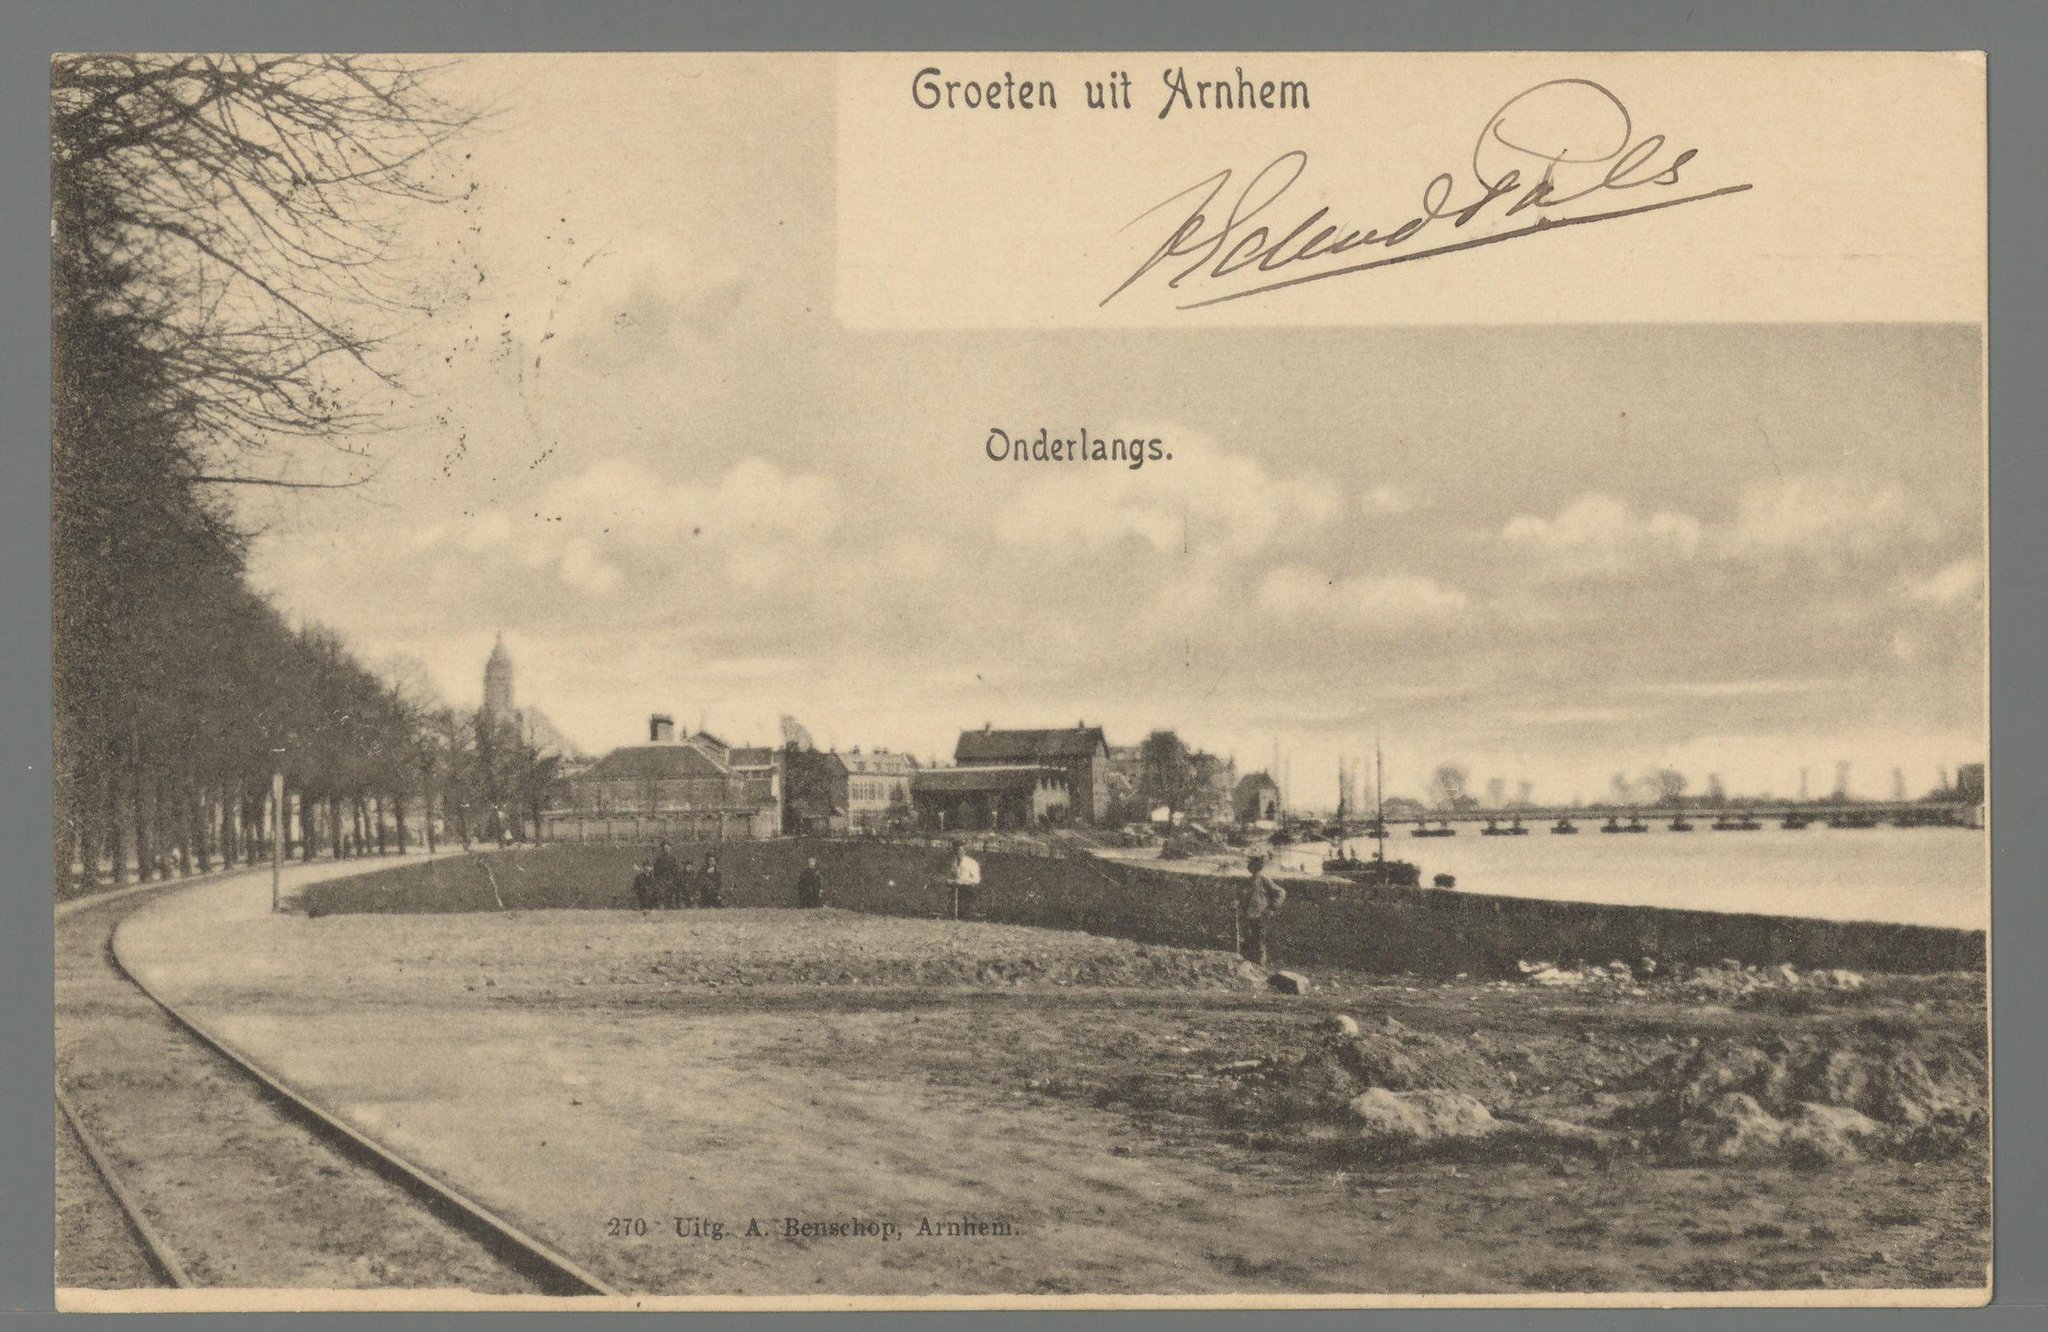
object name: photomechanical print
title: Groeten uit Arnhem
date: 1892-1905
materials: cardboard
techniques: photograph, writing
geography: arnhem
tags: city-view in general; 'veduta', arnhem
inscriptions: postage stamp